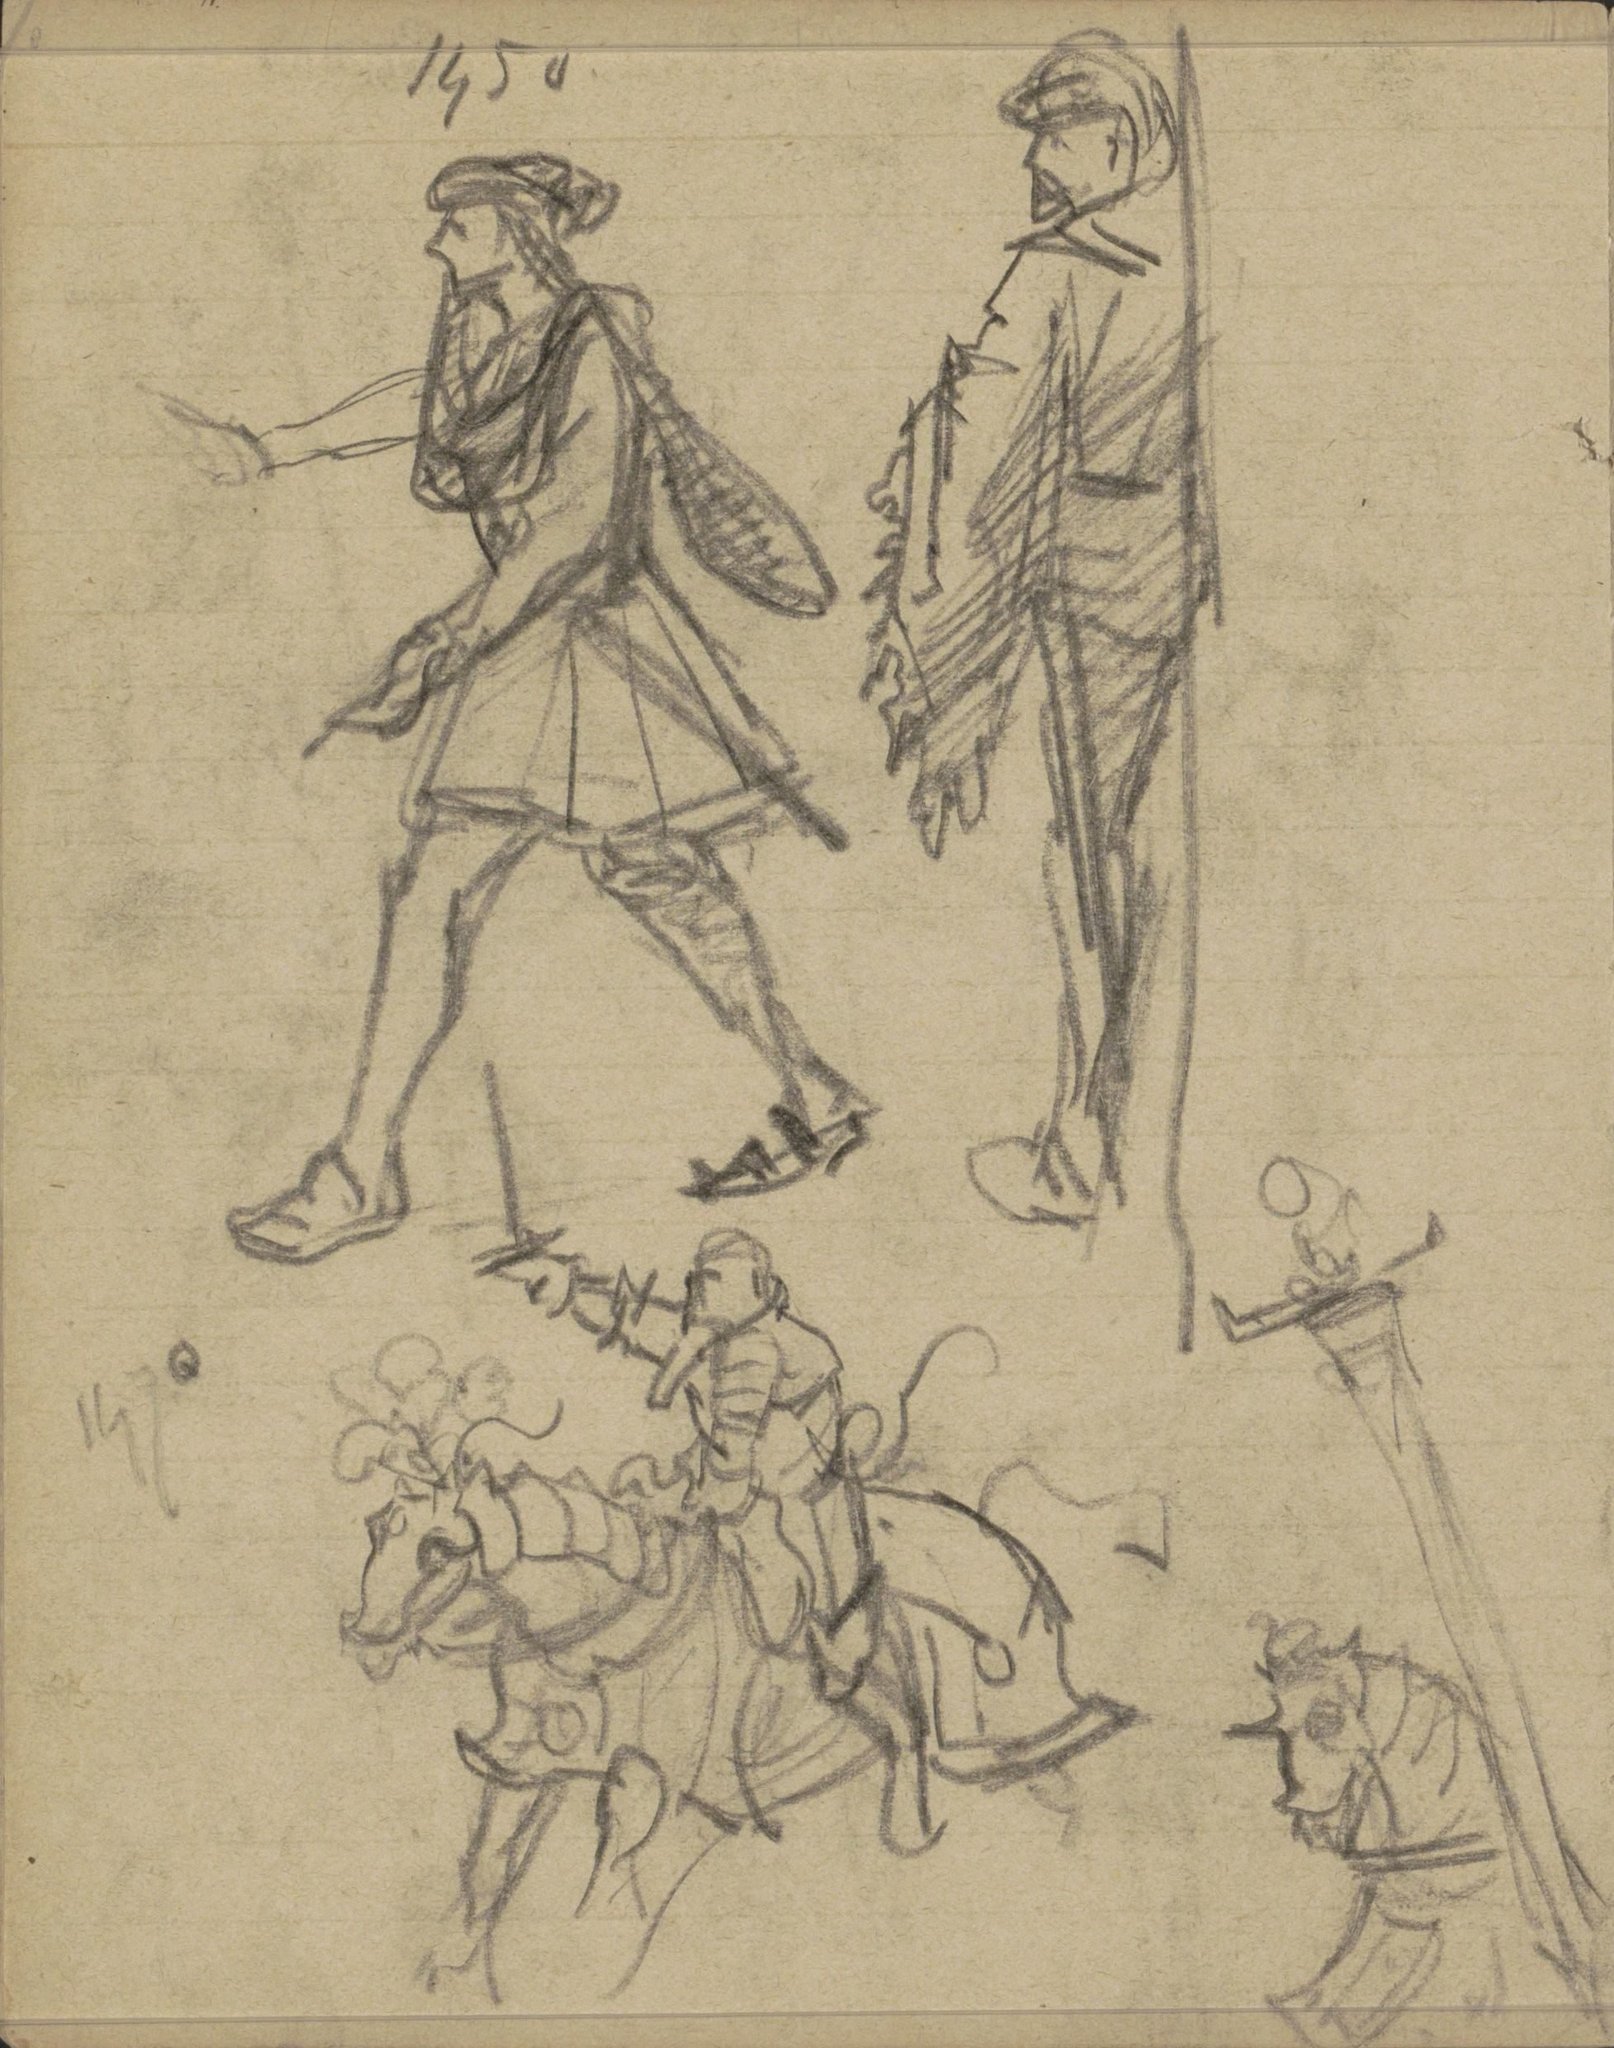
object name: sketchbook leaf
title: Figuren in kostuums uit 1450-1470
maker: marius bauer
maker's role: draughtsman, print maker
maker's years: 1867-1932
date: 1885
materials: charcoal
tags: hacking and thrusting weapons, adult man, historical costume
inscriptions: annotation: ‘1450/ 1470’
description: De figuren dragen ridderkostuums. Eén ridder is te paard getekend met een zwaard in de hand. Pagina 8 uit een schetsboek met 6 bladen.